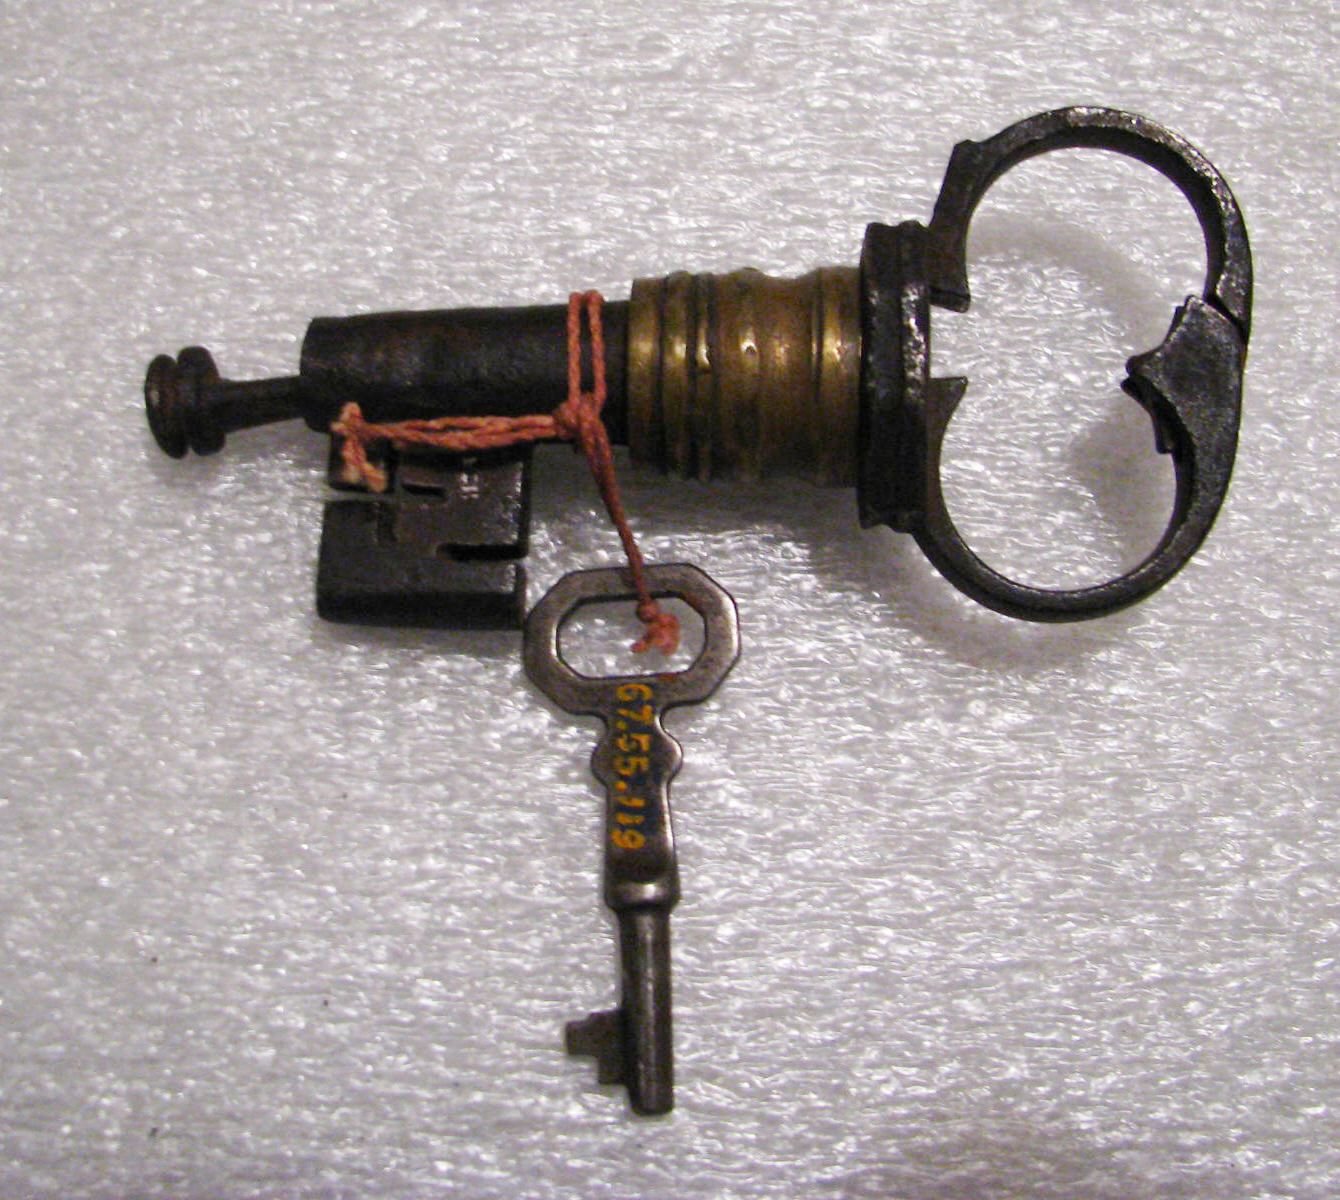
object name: padlock with key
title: Key padlock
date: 1701-1800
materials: brass, iron, steel